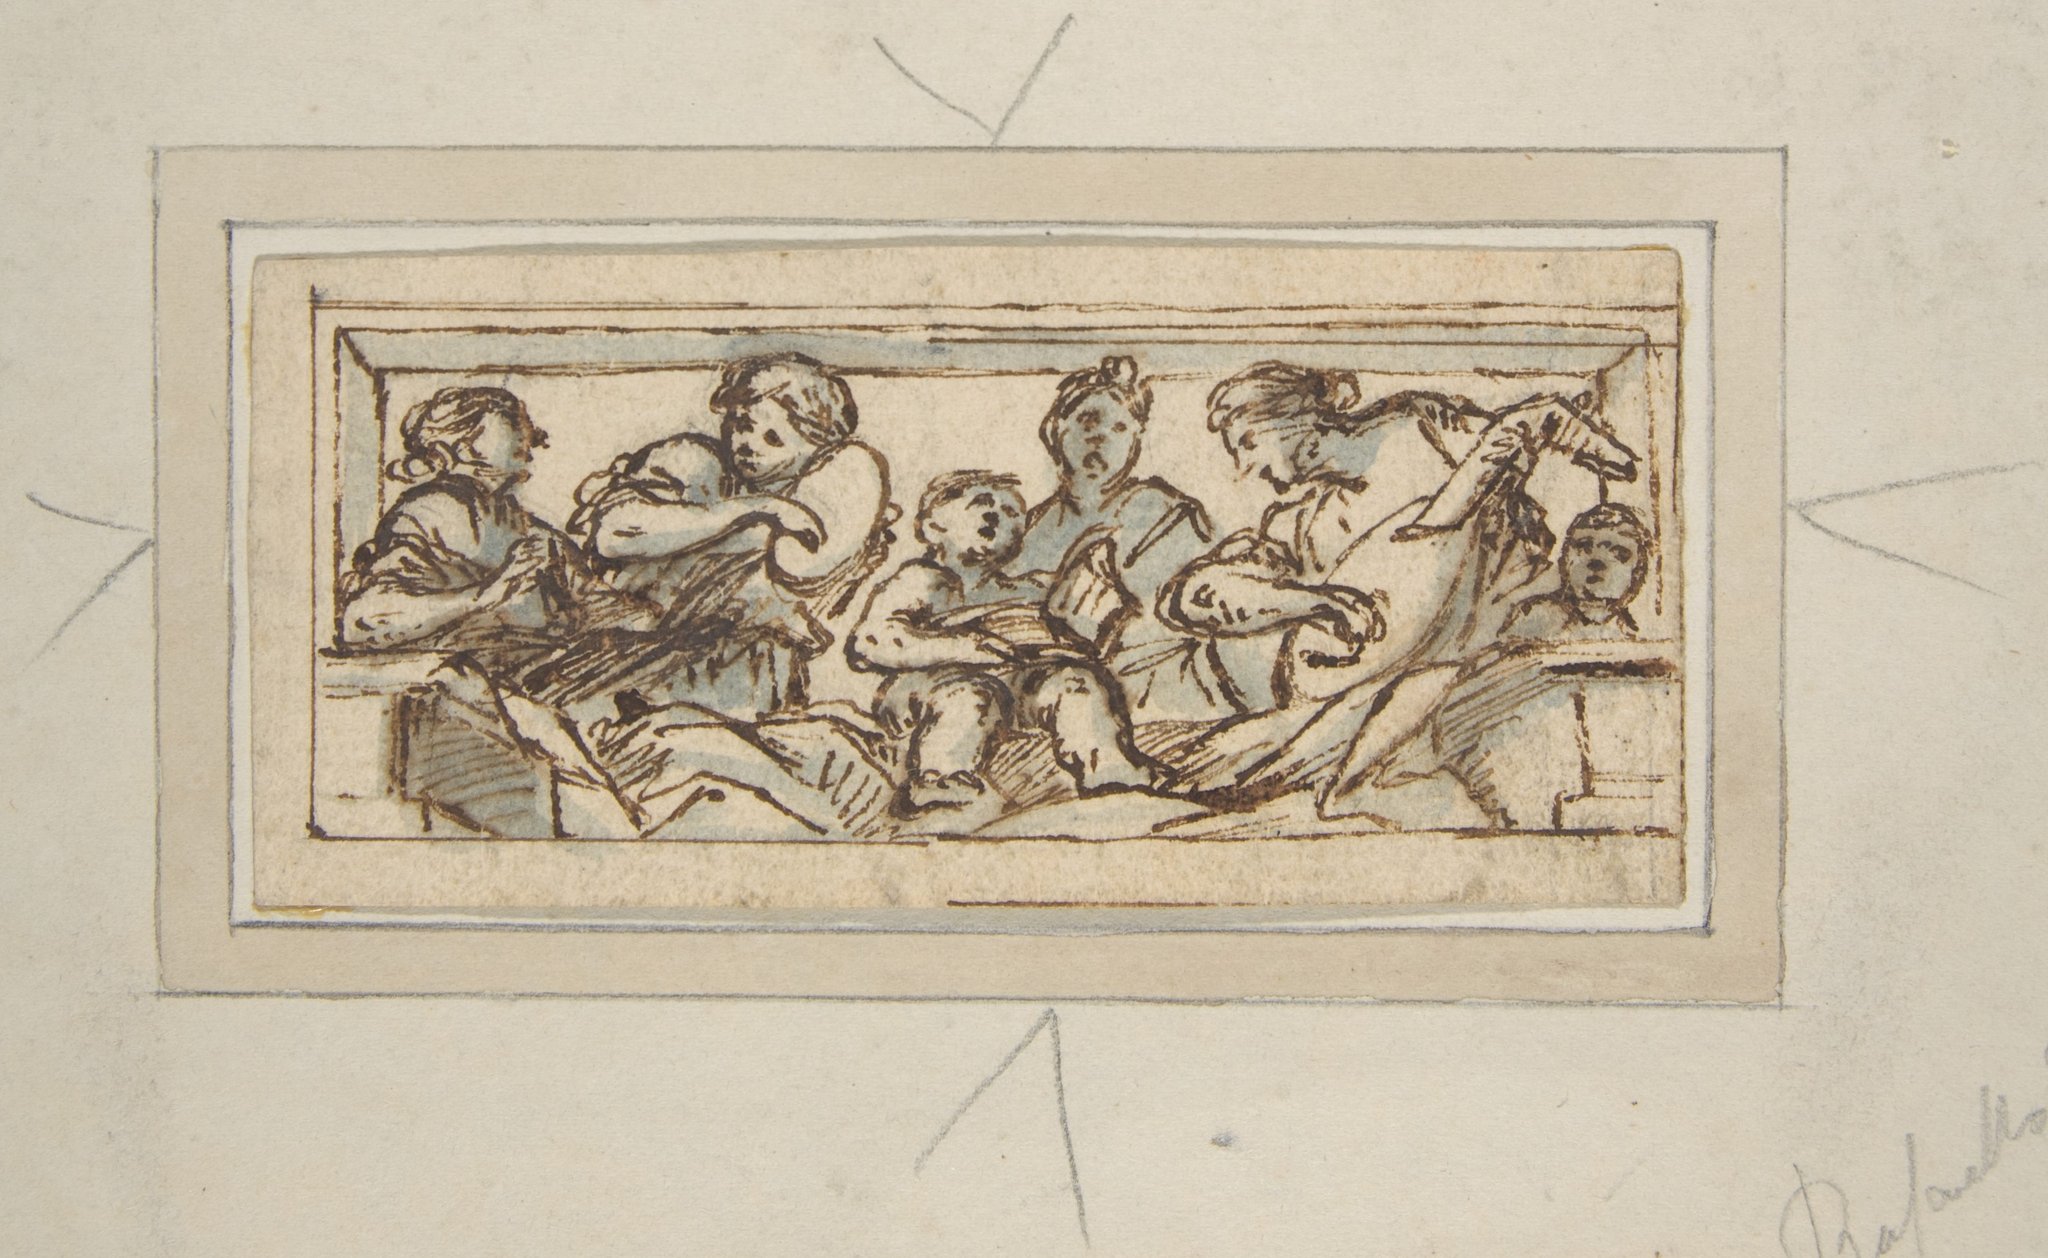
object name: drawing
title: Six Music-Making Figures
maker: giovanni francesco romanelli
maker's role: artist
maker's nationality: italian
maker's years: 1610-1662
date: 1610-1662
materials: ink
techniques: brush, pen, wash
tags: men,music,lutes,musicians